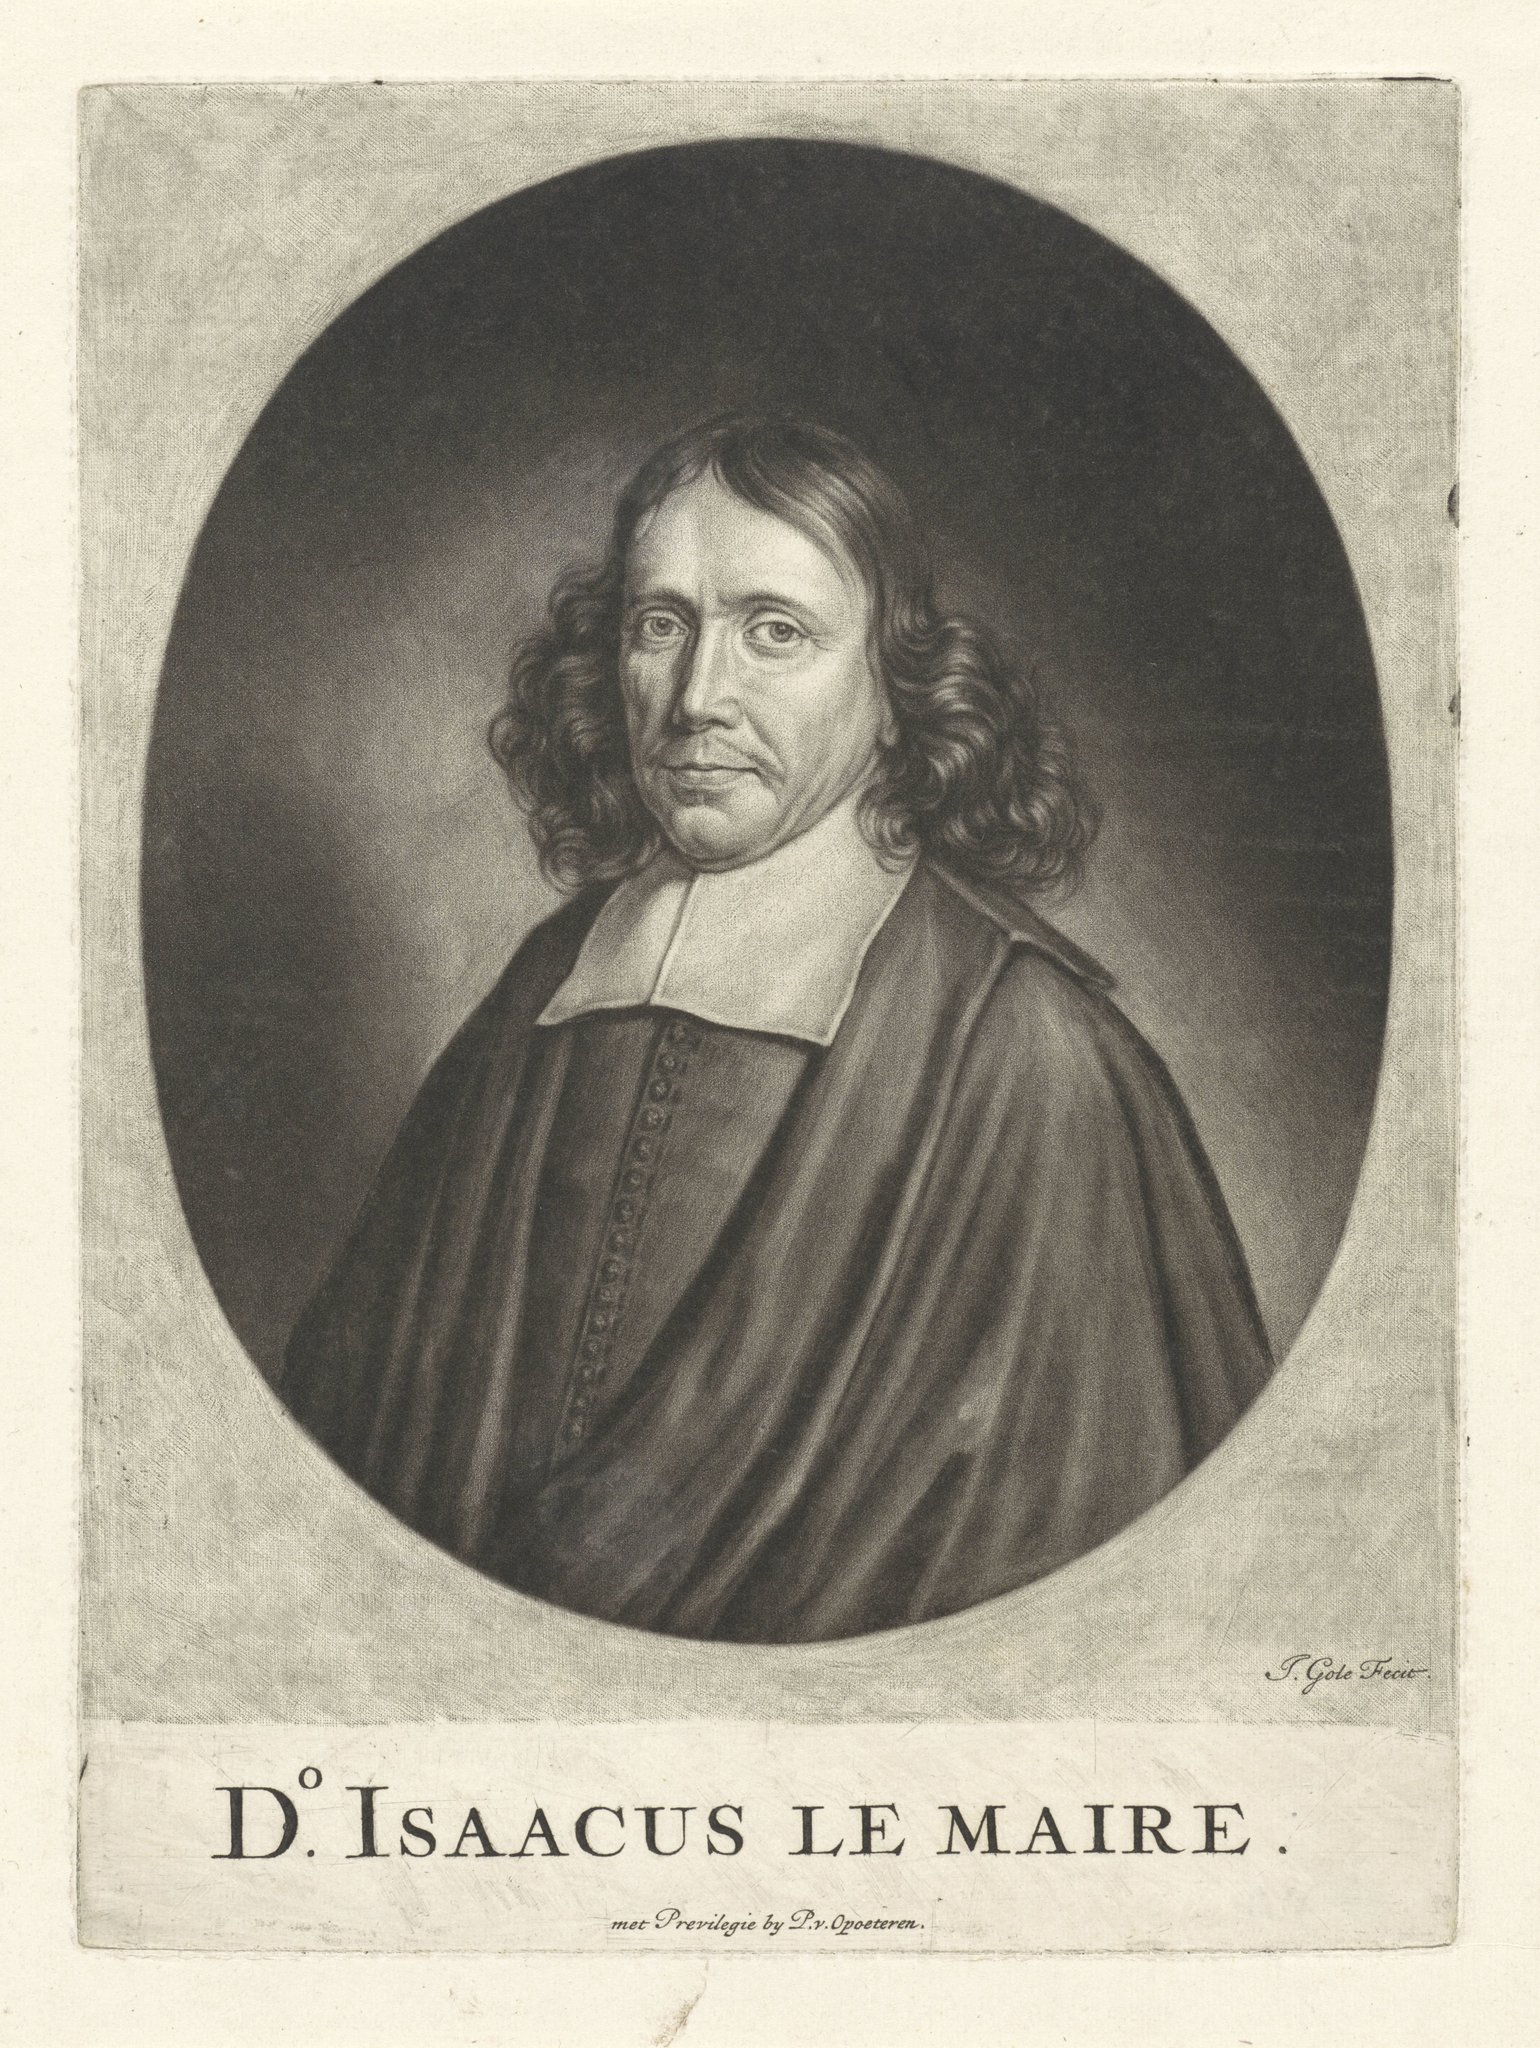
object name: print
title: Portret van Isaac Le Maire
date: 1675-1699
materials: paper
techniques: engraving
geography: amsterdam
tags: amsterdam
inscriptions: collector's mark: Lugt 2228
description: Isaac Le Maire, predikant en dichter te Amsterdam.